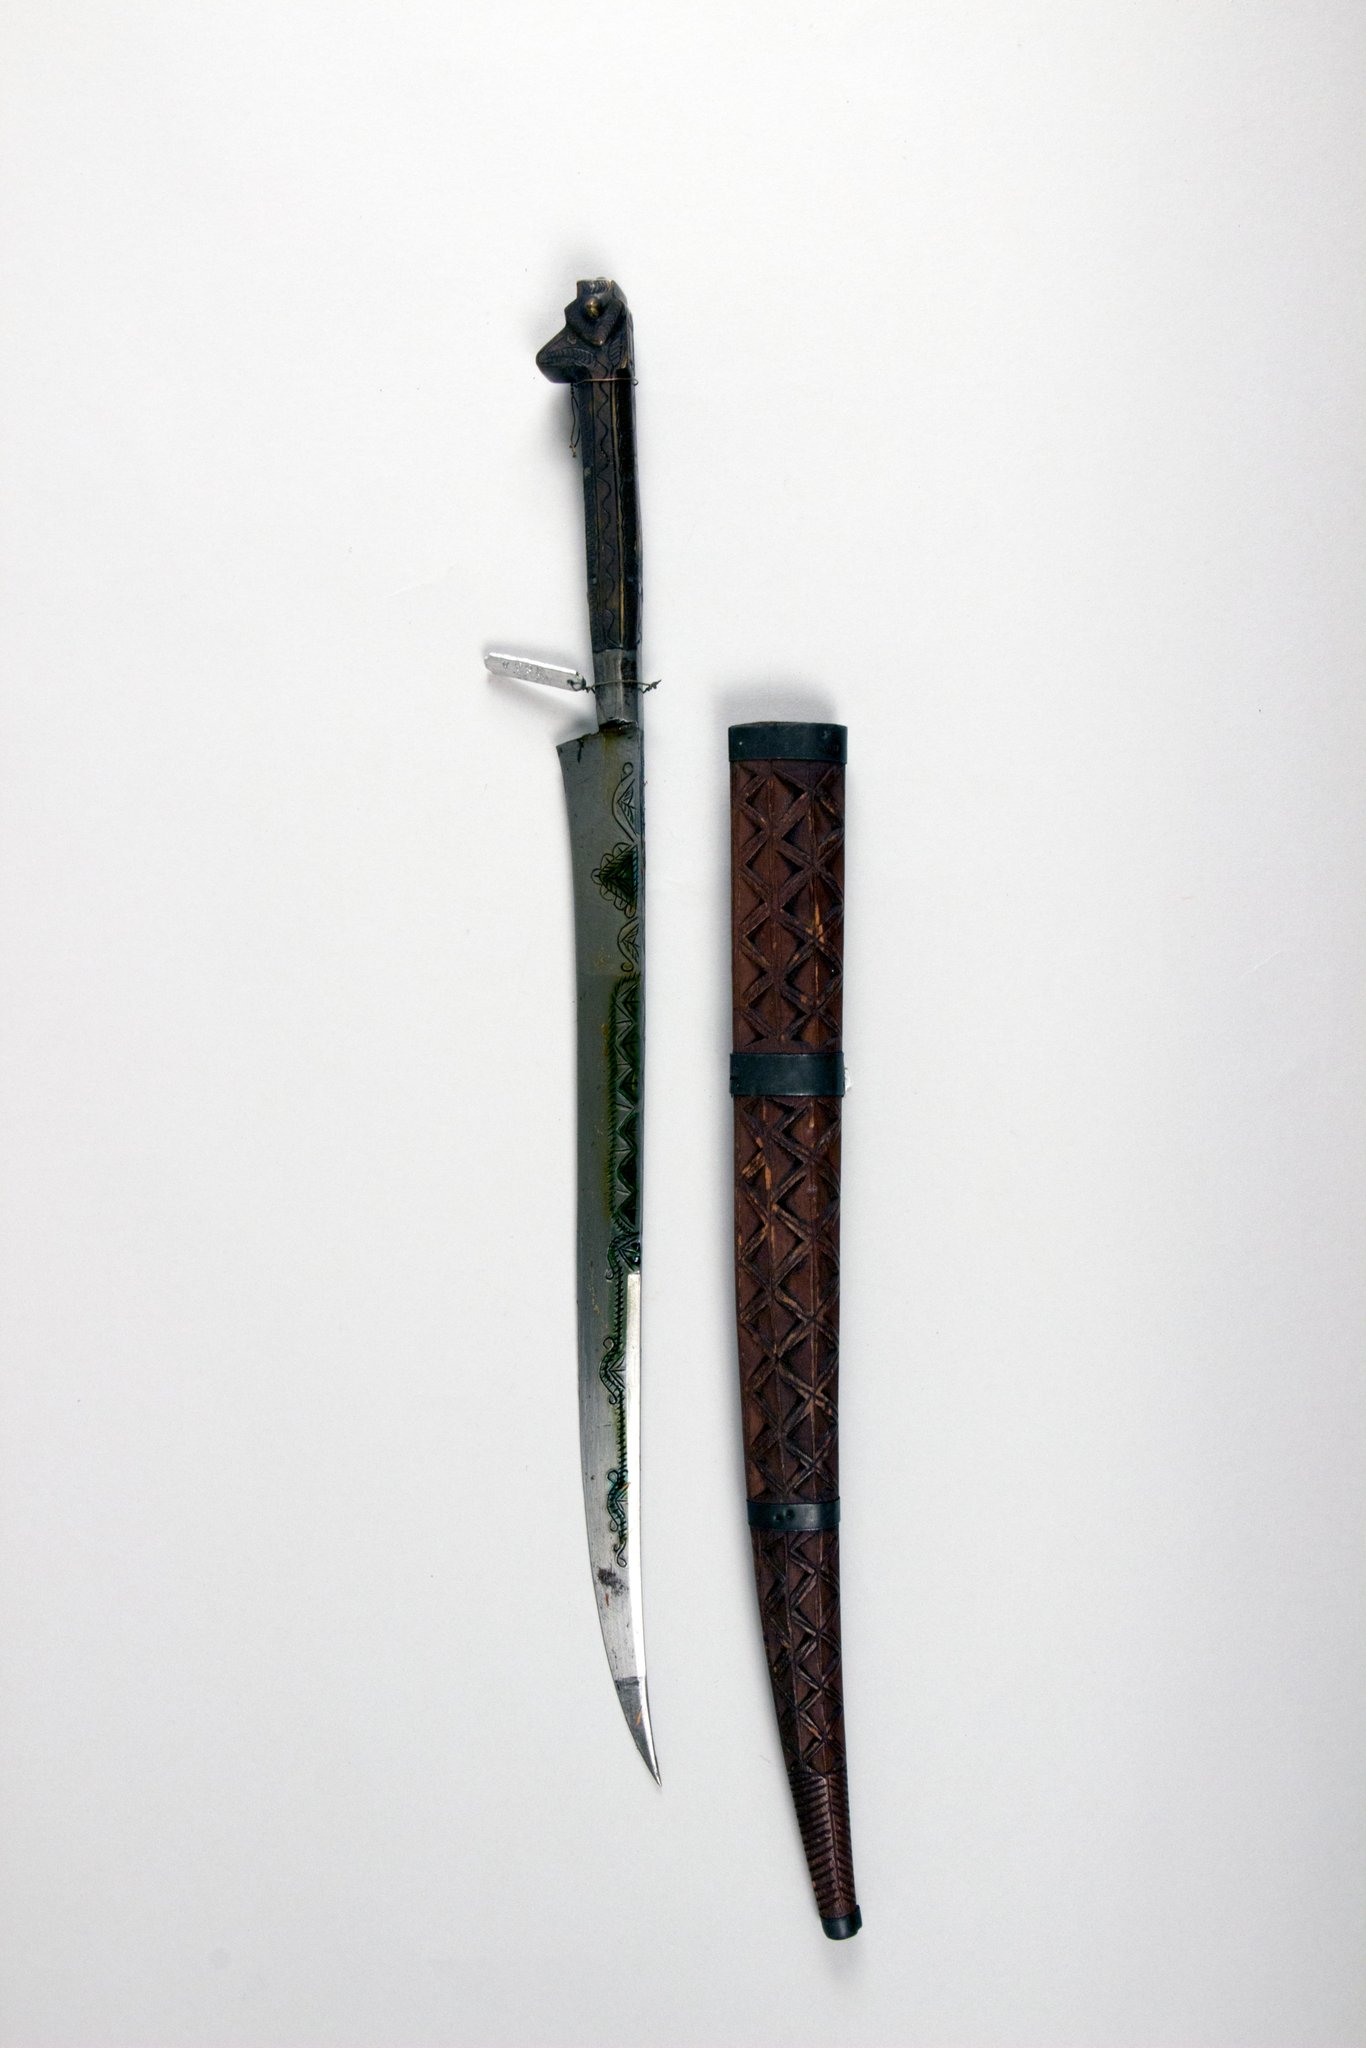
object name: knife flyssa with sheath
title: Knife (Flyssa) with Sheath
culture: algerian or kabyle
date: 1801-1900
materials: brass, iron, steel, wood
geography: morocco